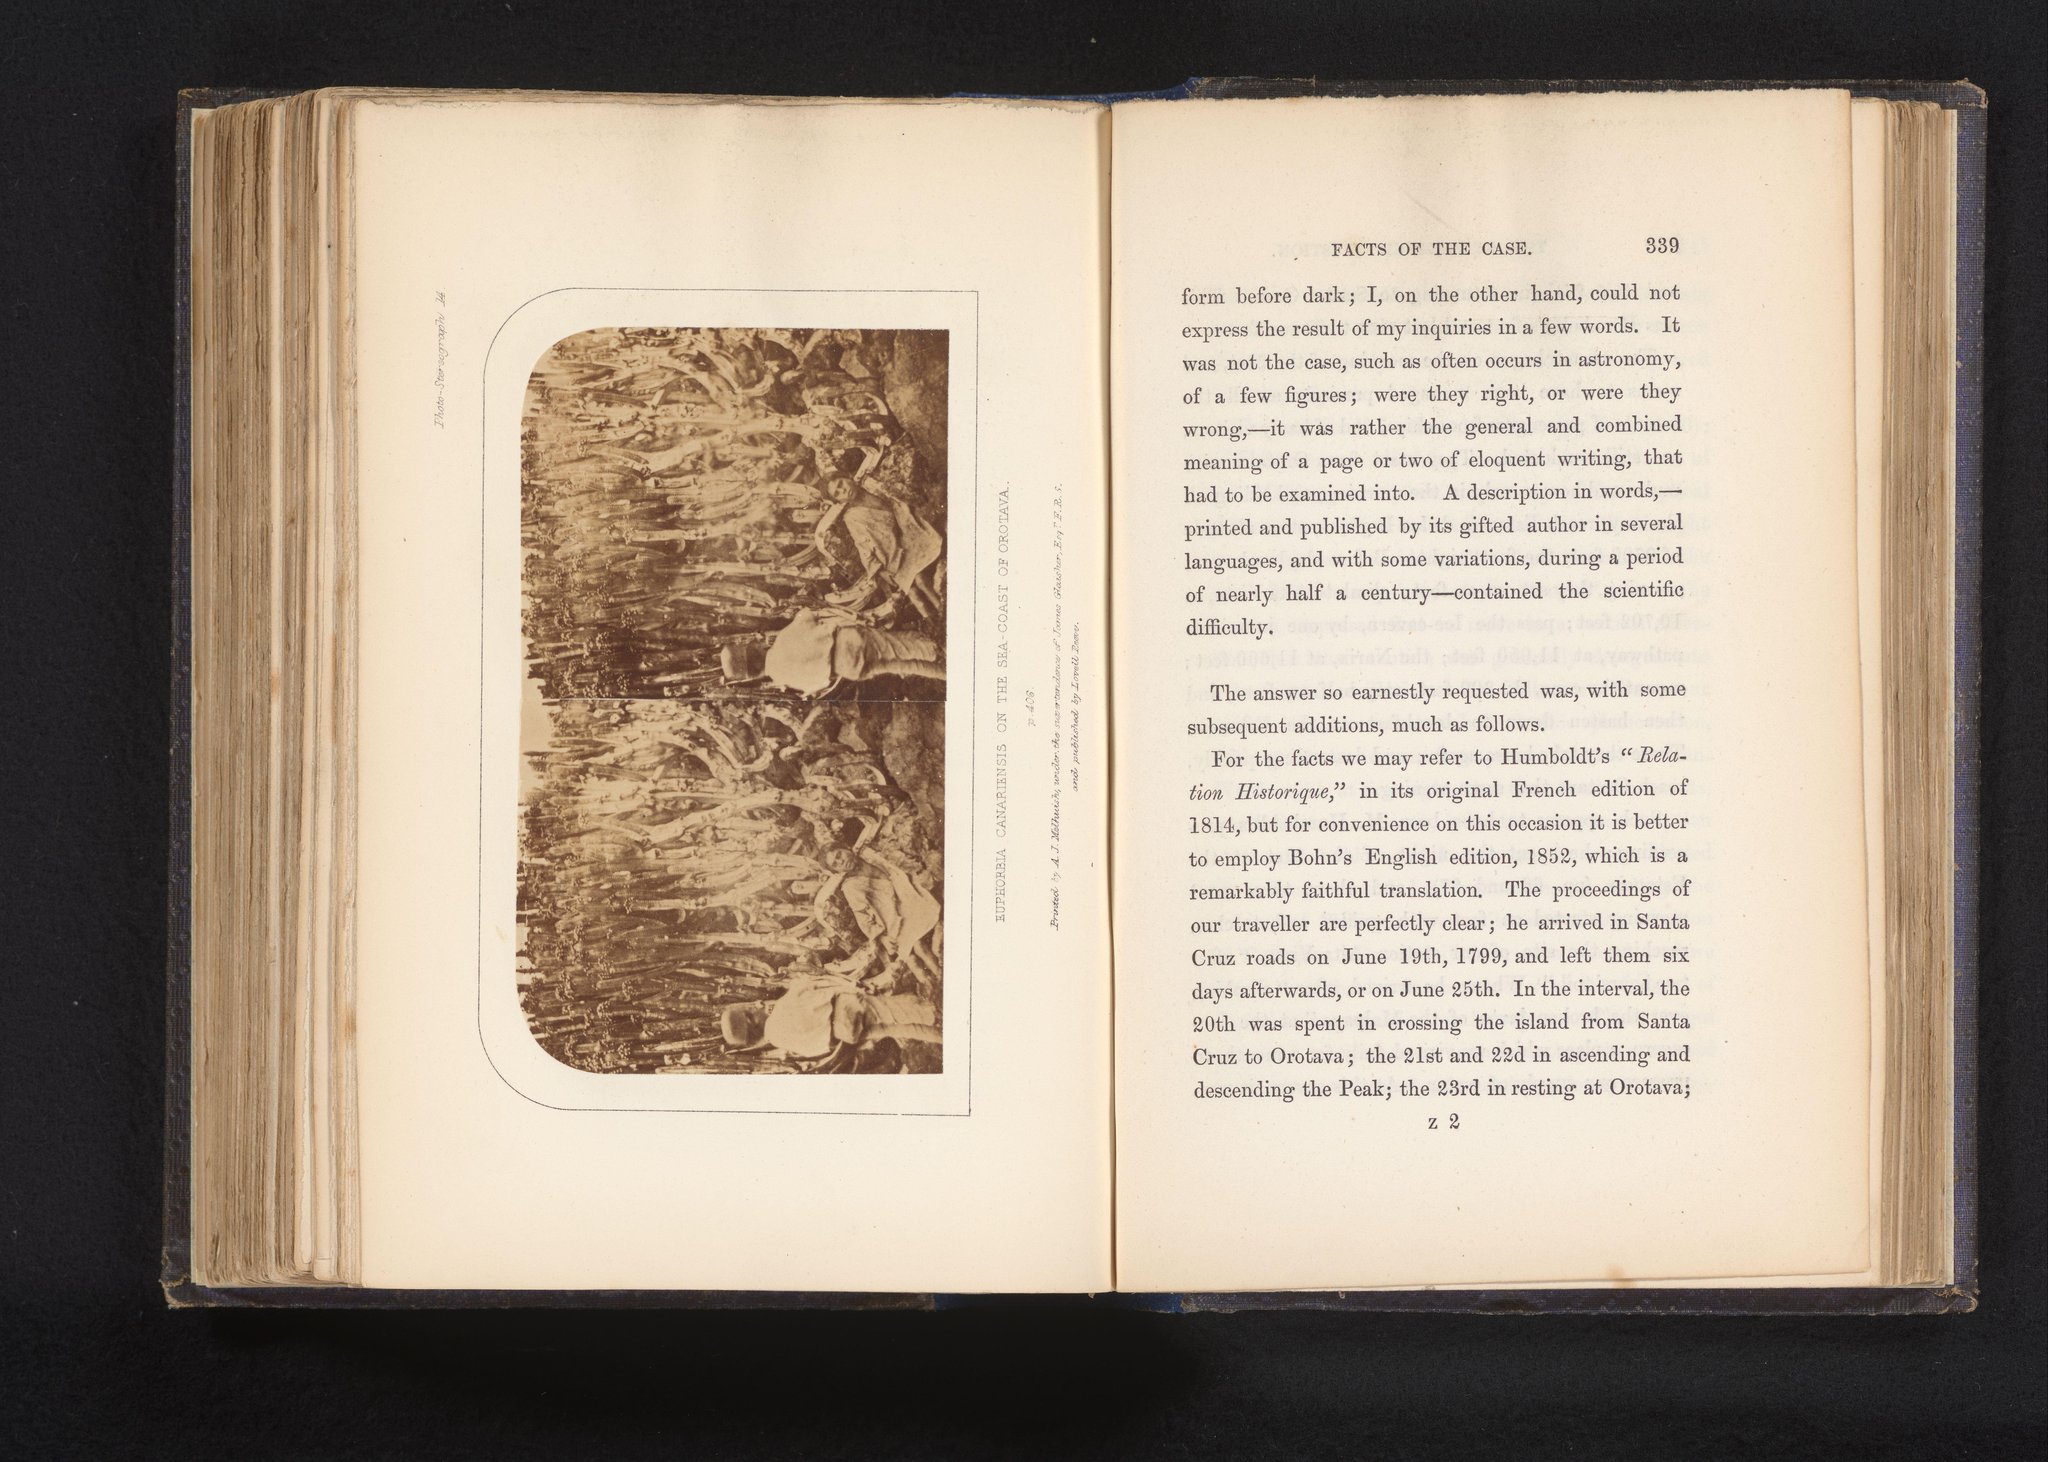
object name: page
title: Euphorbia Canariensis on the sea-coast of Orotava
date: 1856-1858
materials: paper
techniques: albumen print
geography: la orotava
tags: plants and herbs: cactus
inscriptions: inscription: ‘Photo-Stereograph 14.’